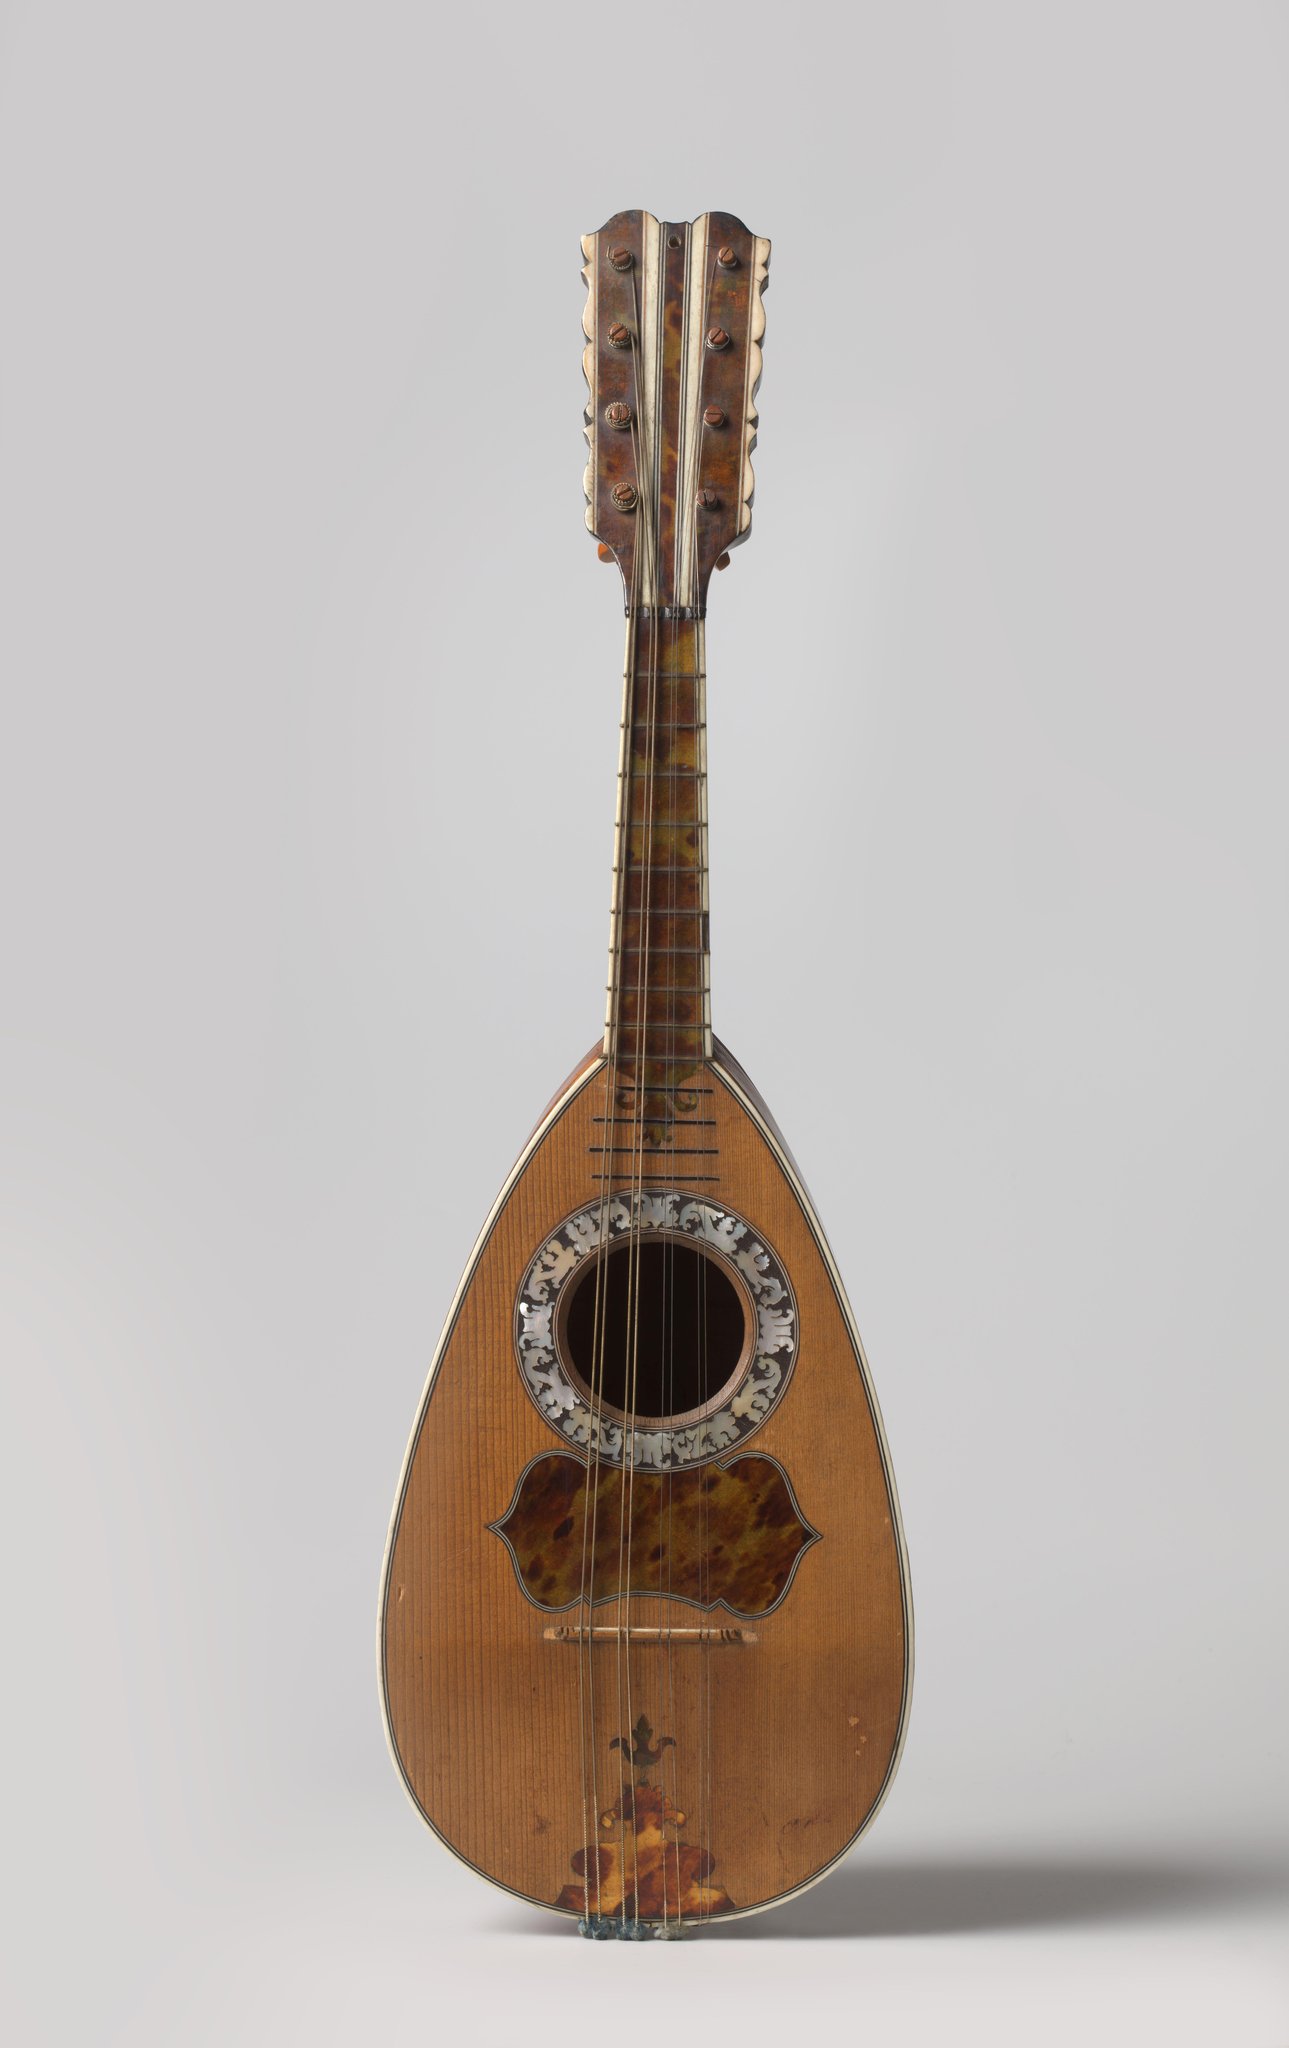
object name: stringed instrument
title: Neapolitan mandolin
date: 1770-1780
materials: wood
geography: naples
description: Napelse mandolinemet schildpad en parelmoer ingelegd.